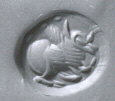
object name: stamp seal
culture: sasanian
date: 401-700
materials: gemstone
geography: iran